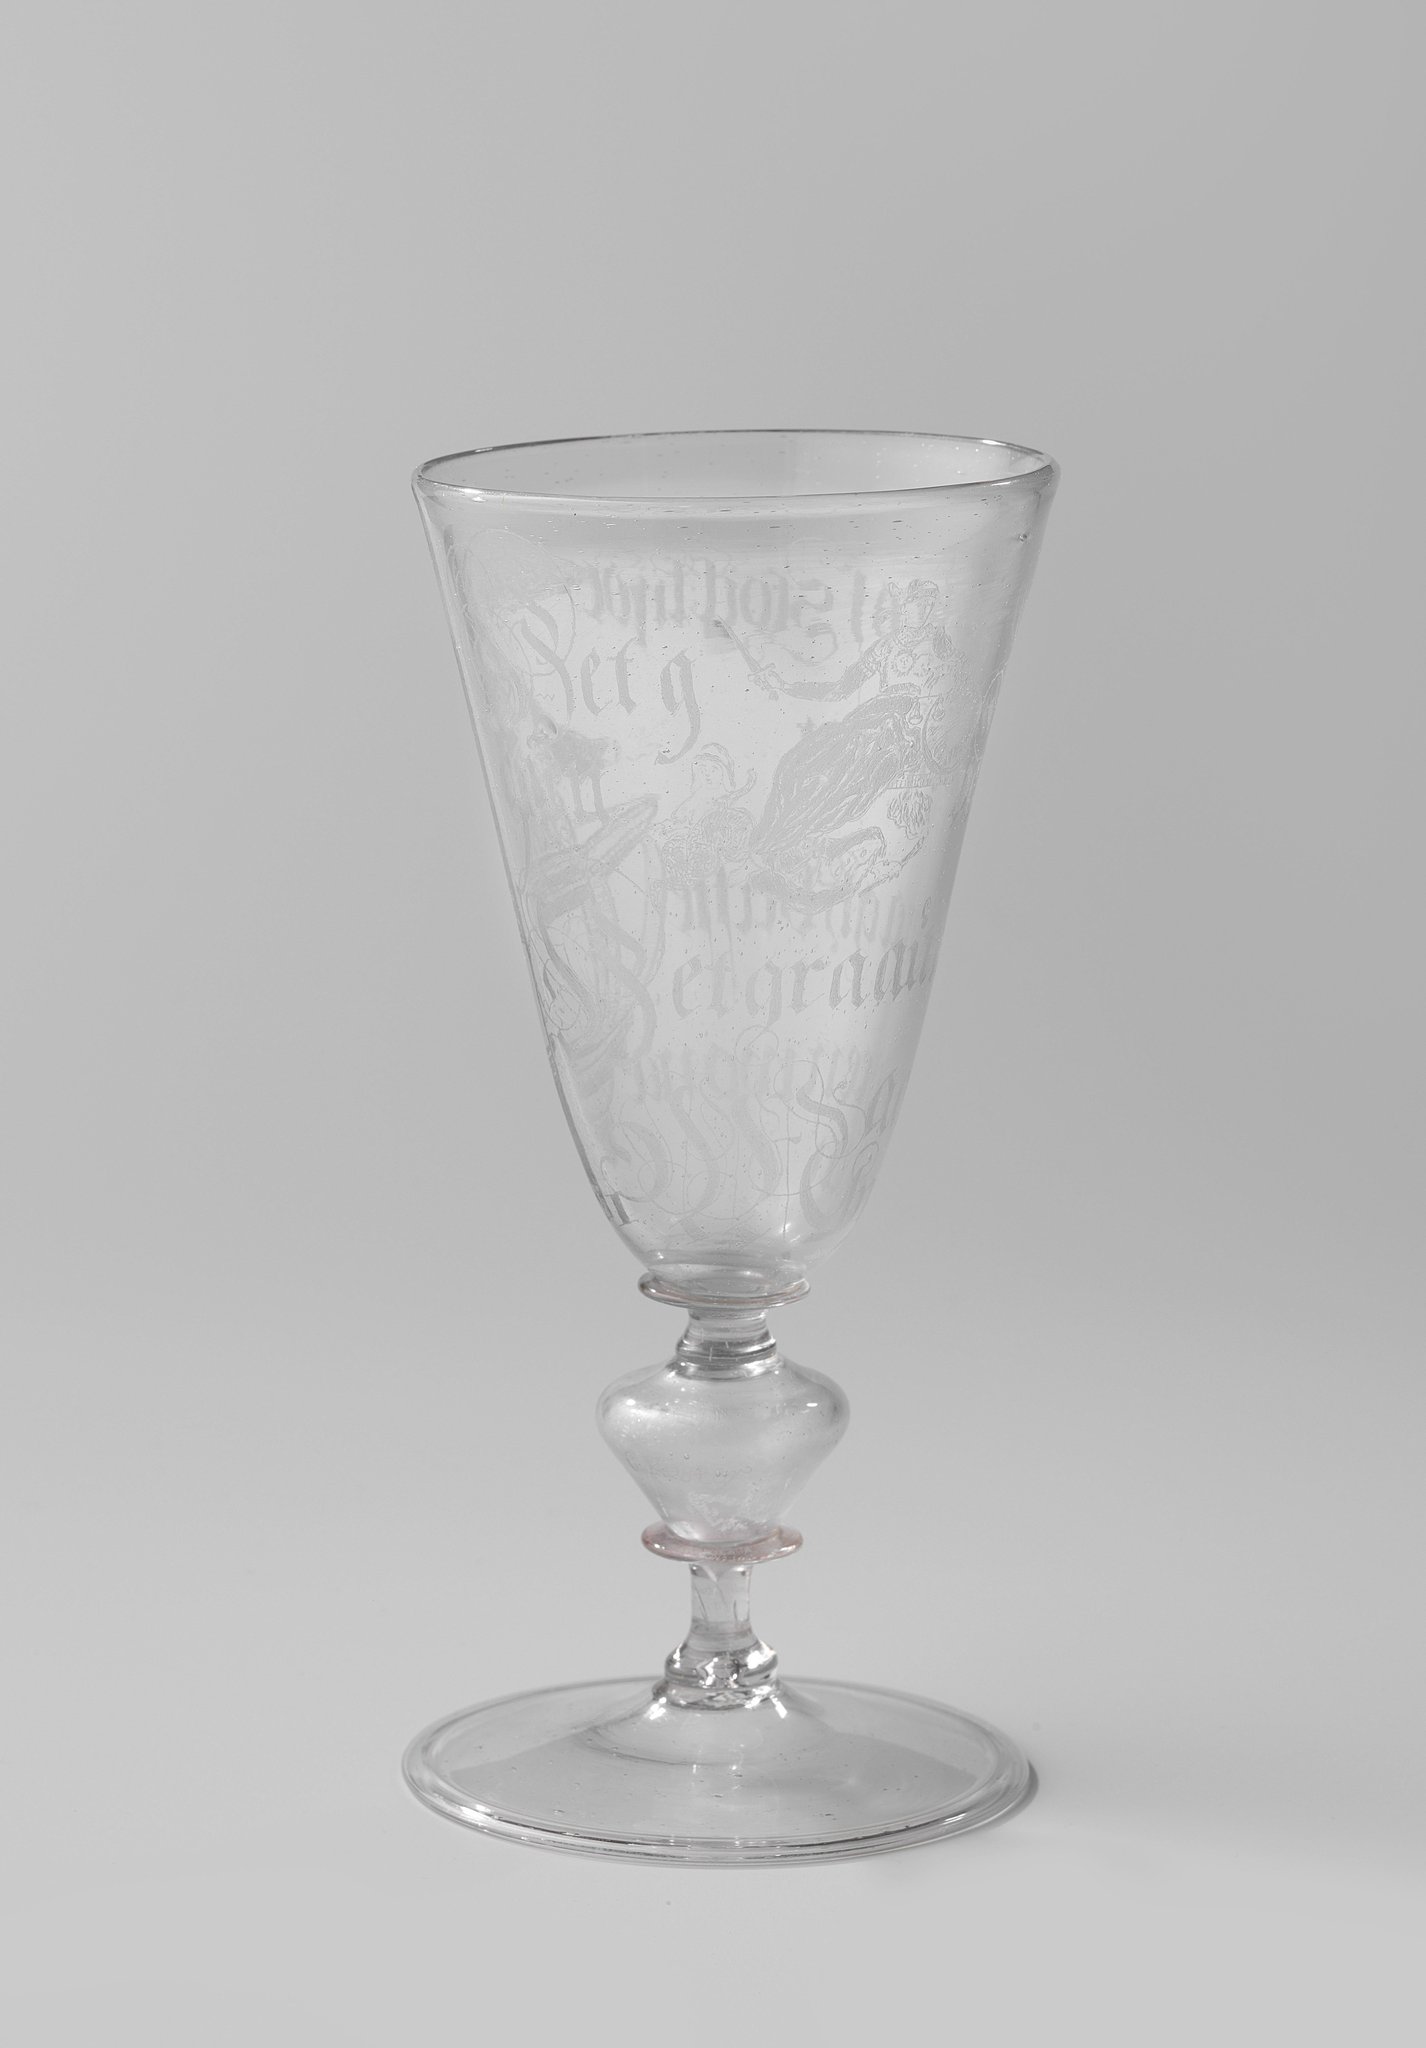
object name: goblet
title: Kelkglas met een predikant, Justitia en een jongen op een slak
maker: Anonymous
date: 1650-1700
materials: glass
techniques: diamond point engraving, façon de venise, glassblowing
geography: low countries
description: Platte voet met omgeslagen rand. Balustervormige, holle stam met één schijf. Conische, aan de onderzijde afgeronde kelk, waarop een, van een kansel prekende, man is gegraveerd. Links van hem een tronende Justitia, geblindoekt, in haar rechter hand een zwaard, in haar linker een weegschaal, haar elleboog rustend op een wereldbol, onder haar voeten drie mannenhoofden en links van haar een slak, bereden door jongetje. In gotische letters het opschrift Het gRecht of Stoil: lijdt geen ver:weijtten Het graauw magh basse Maar geen wond Byten.